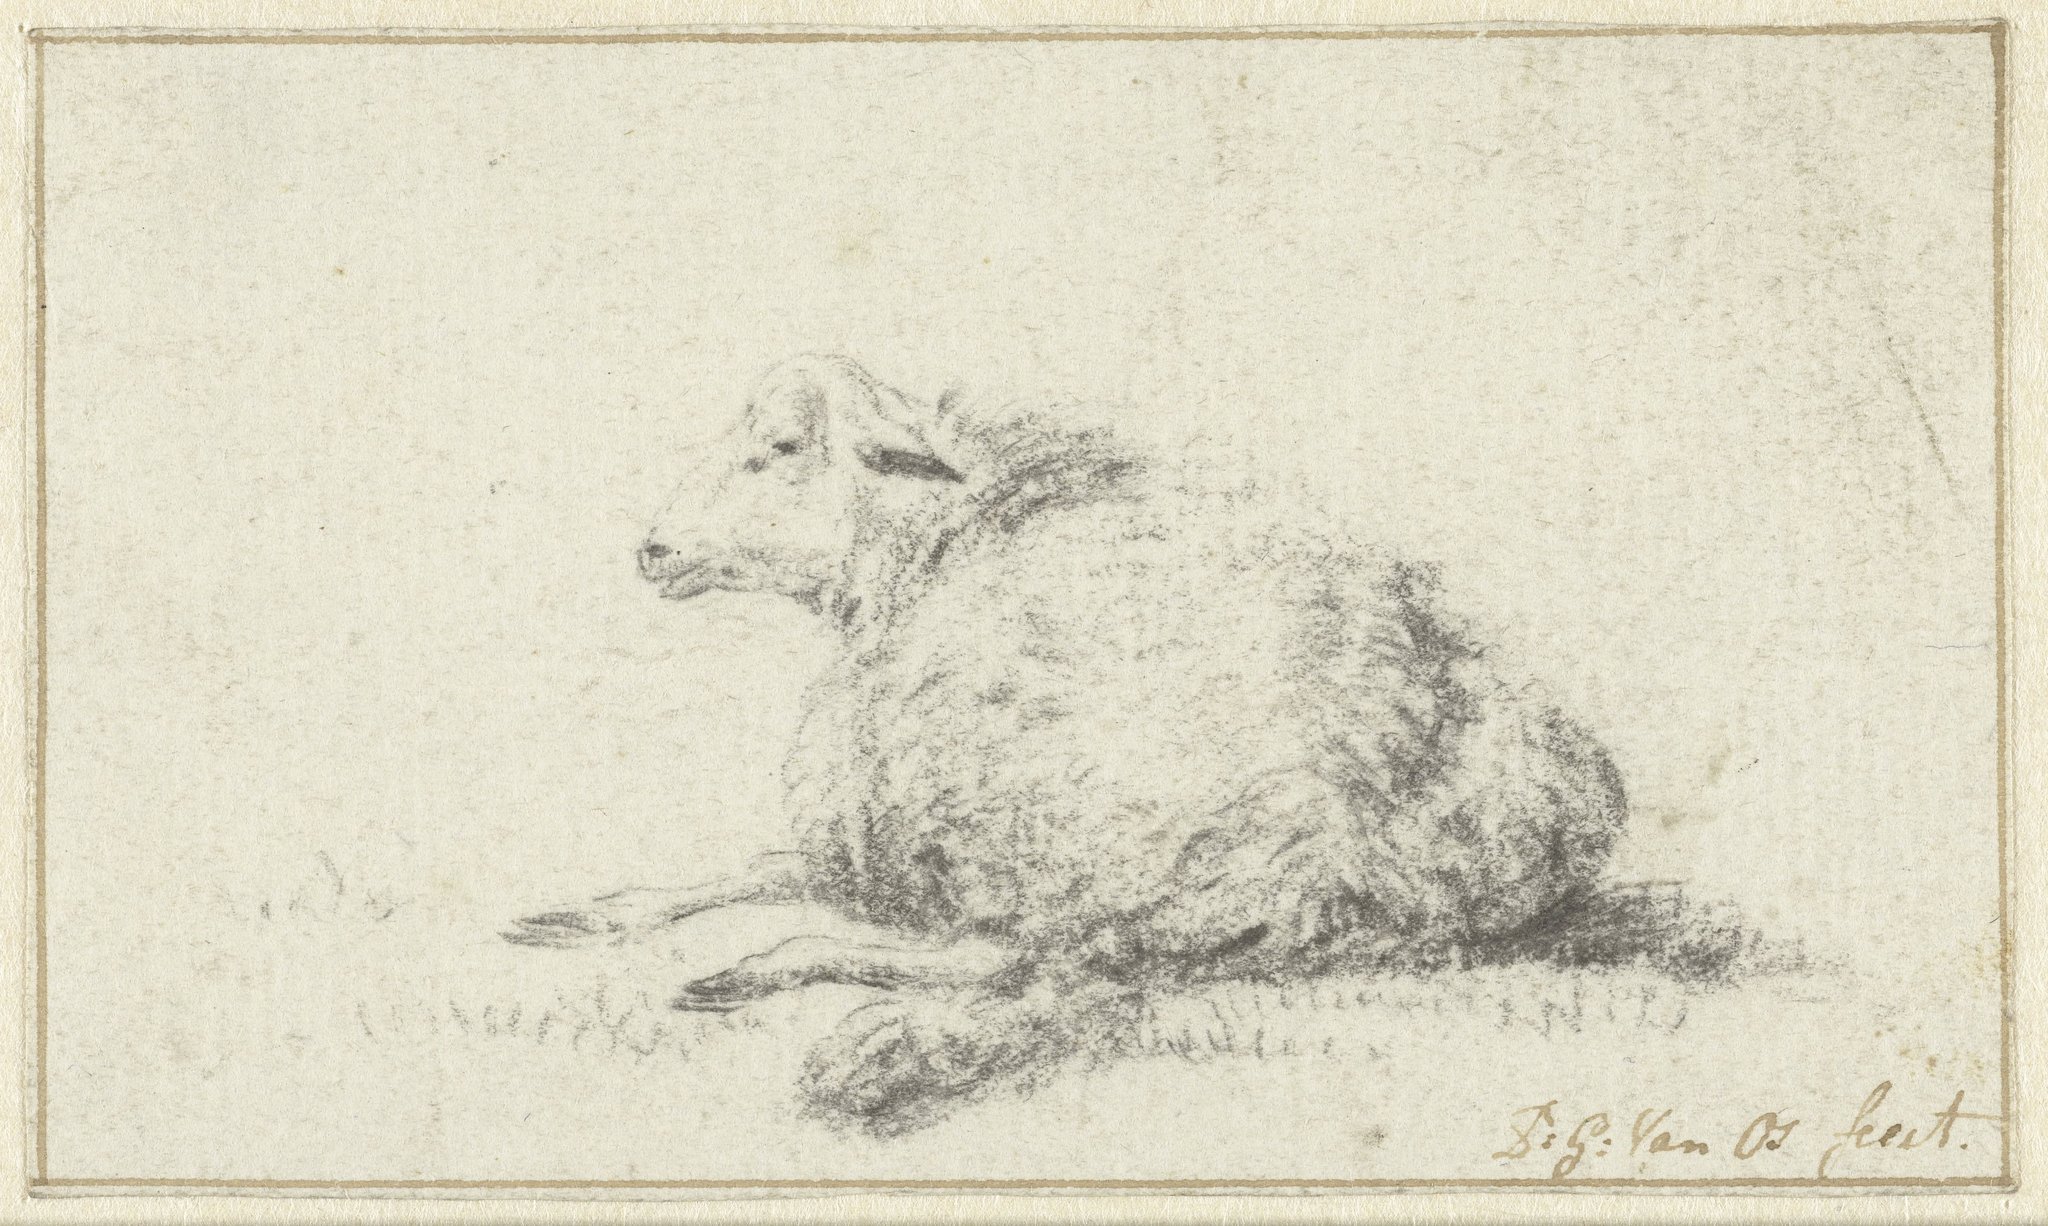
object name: drawing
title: Liggend schaap, schuin van achteren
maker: pieter gerardus van os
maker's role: draughtsman, painter, print maker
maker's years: 1776-1839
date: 1786-1839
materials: paper, pencil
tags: sheep